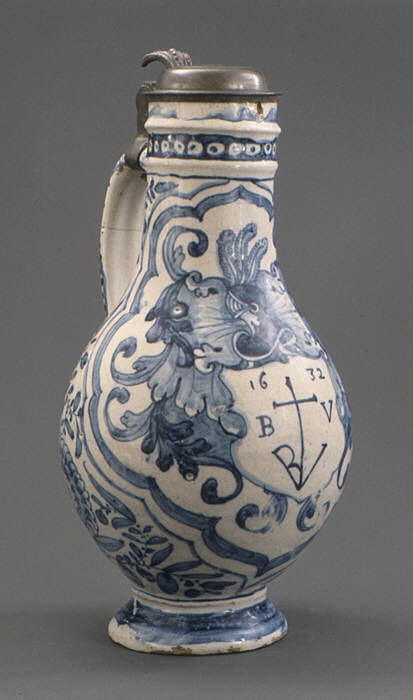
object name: krug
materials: faience, pewter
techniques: glazing